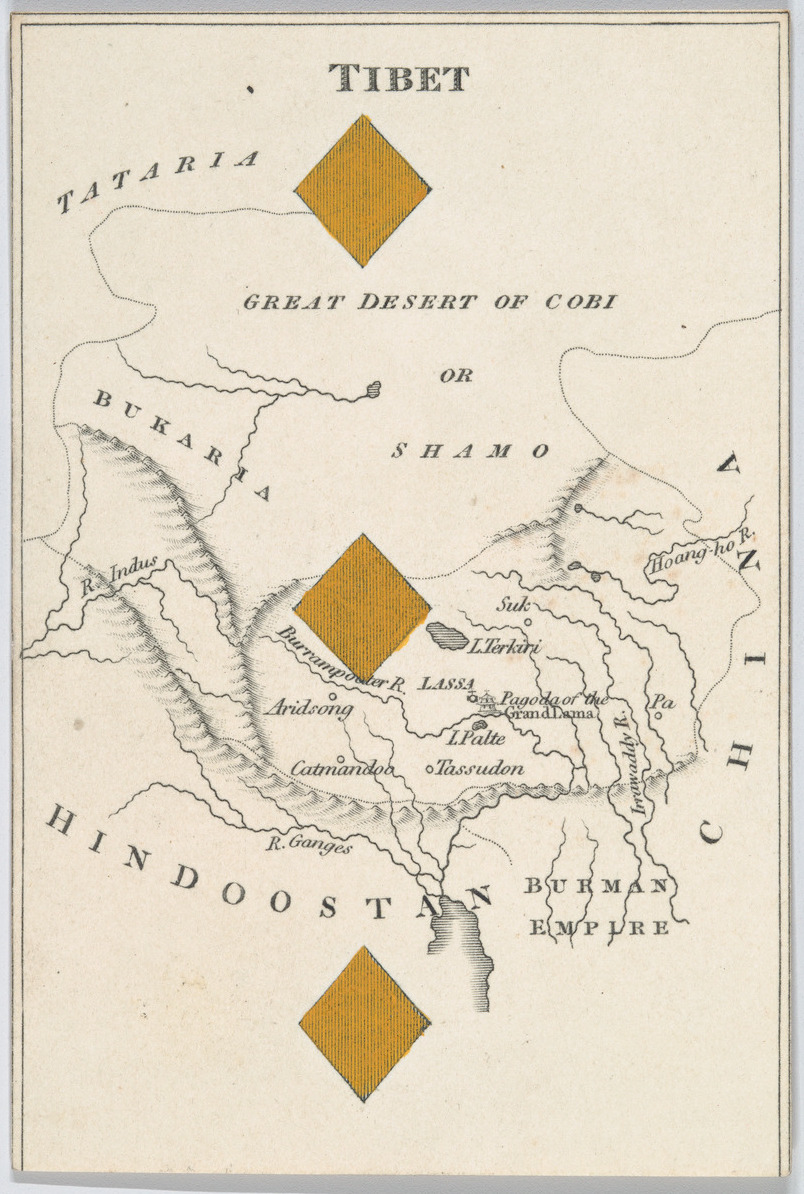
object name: print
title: Tibet, from "Court Game of Geography"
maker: william and henry rock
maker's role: publisher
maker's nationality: british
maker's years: 1821-1884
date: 1838-1855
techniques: engraving, hand coloring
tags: playing cards,maps